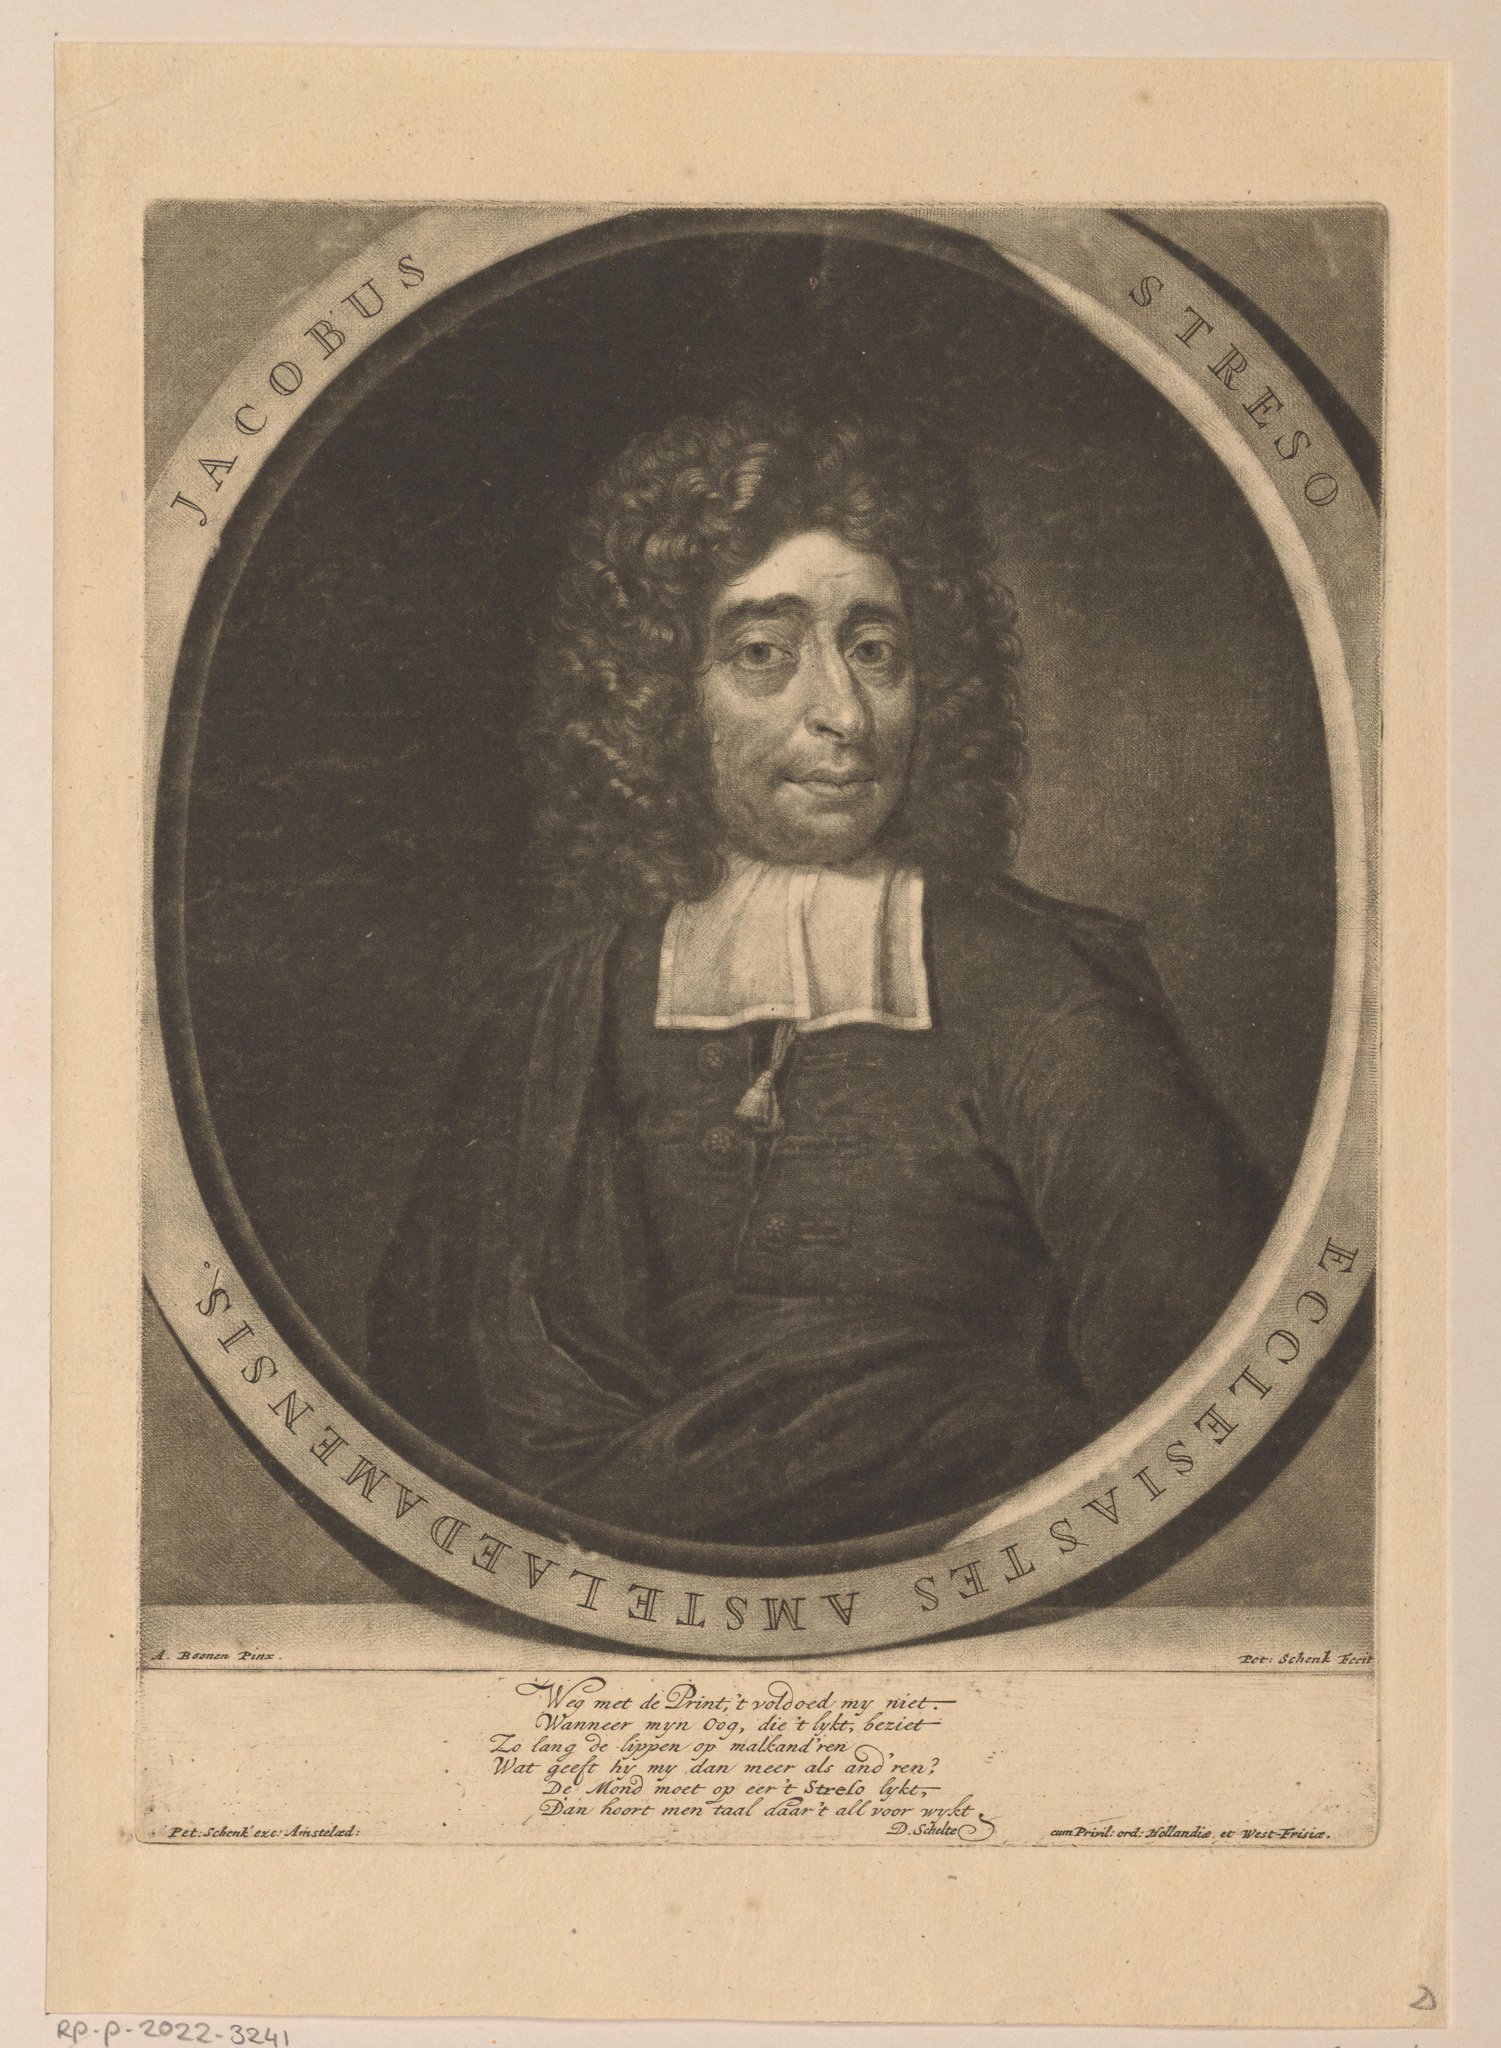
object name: print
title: Portret van Jacobus Streso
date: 1678-1713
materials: paper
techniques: engraving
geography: amsterdam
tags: amsterdam, historical persons, functionaries and dignitaries (with name) ~ episcopal protestant churches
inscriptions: collector's mark: Lugt 964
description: Met zesregelig onderschrift in het Nederlands en tekst in het Latijn rondom het portret.